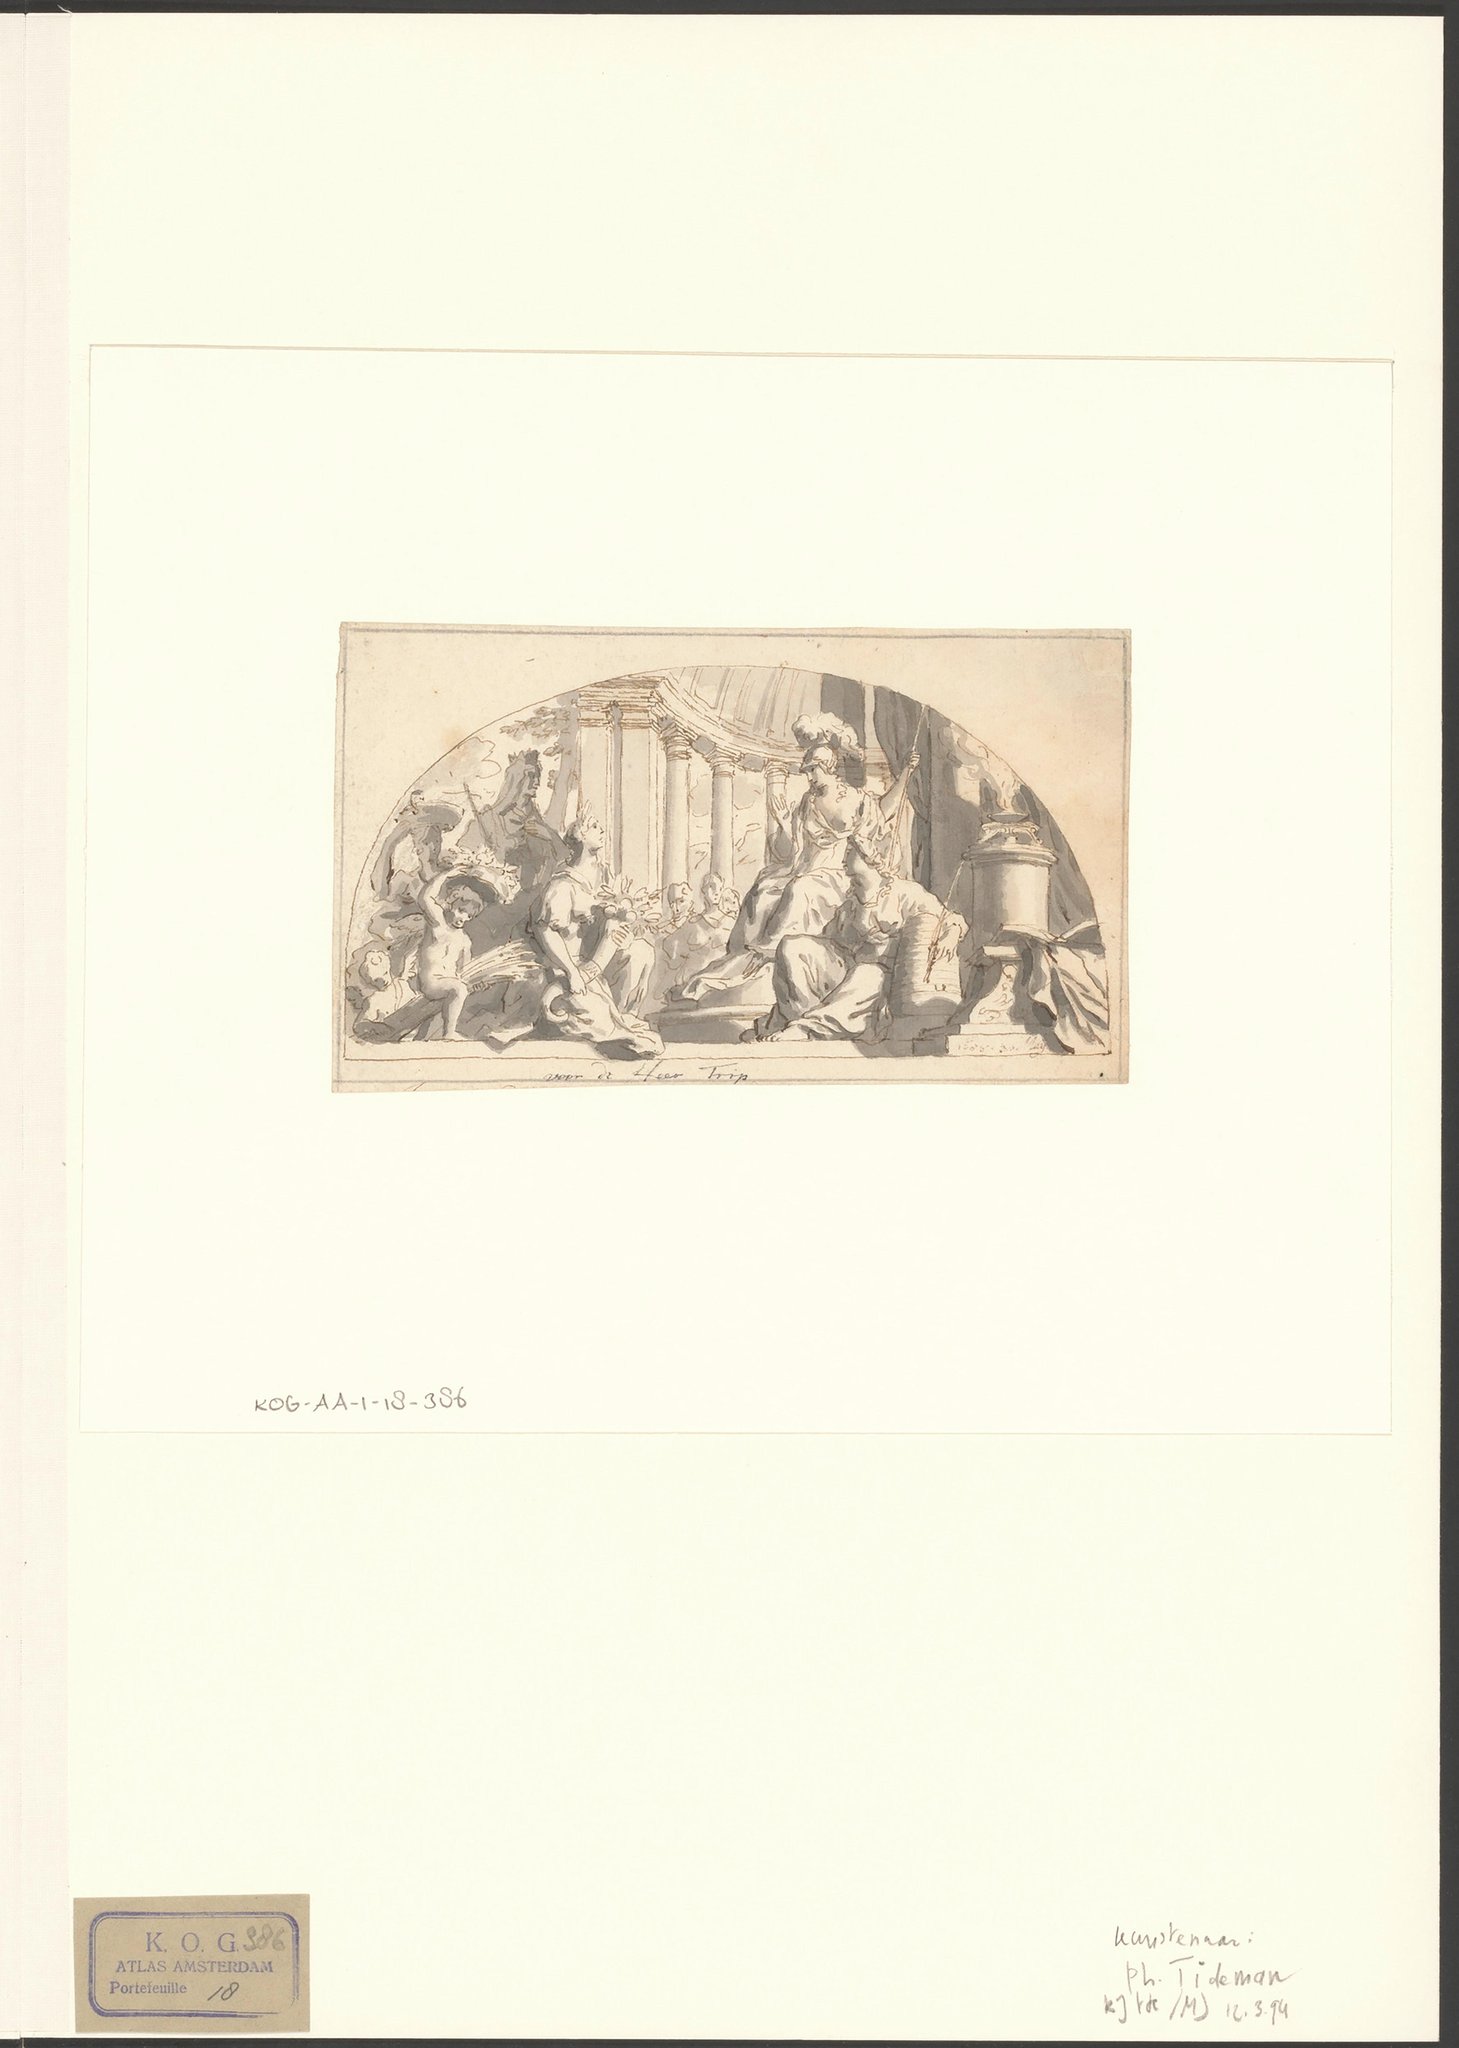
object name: drawing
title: Ceres geknield voor tronende Minerva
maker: philip tidemann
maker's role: draughtsman, painter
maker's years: 1657-1705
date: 1685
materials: ink, paper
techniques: brush, pen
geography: amsterdam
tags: (story of) minerva (pallas, athena), ceres, patroness of agriculture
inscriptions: inscription: ‘kunstenaar: / Ph. Tideman / kj vd /M) 12.3.94’, inscription: ‘voor de Heer Trip / 1685 [...] M[...]’, inscription: ‘Port. 18-386’, collector's mark: ‘18’ Lugt 1641b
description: Onderwerpsrubriek binnen de Atlas Amsterdam: Herinneringen aan regeringsleden en hunne huisgezinnen. [voor 1800].